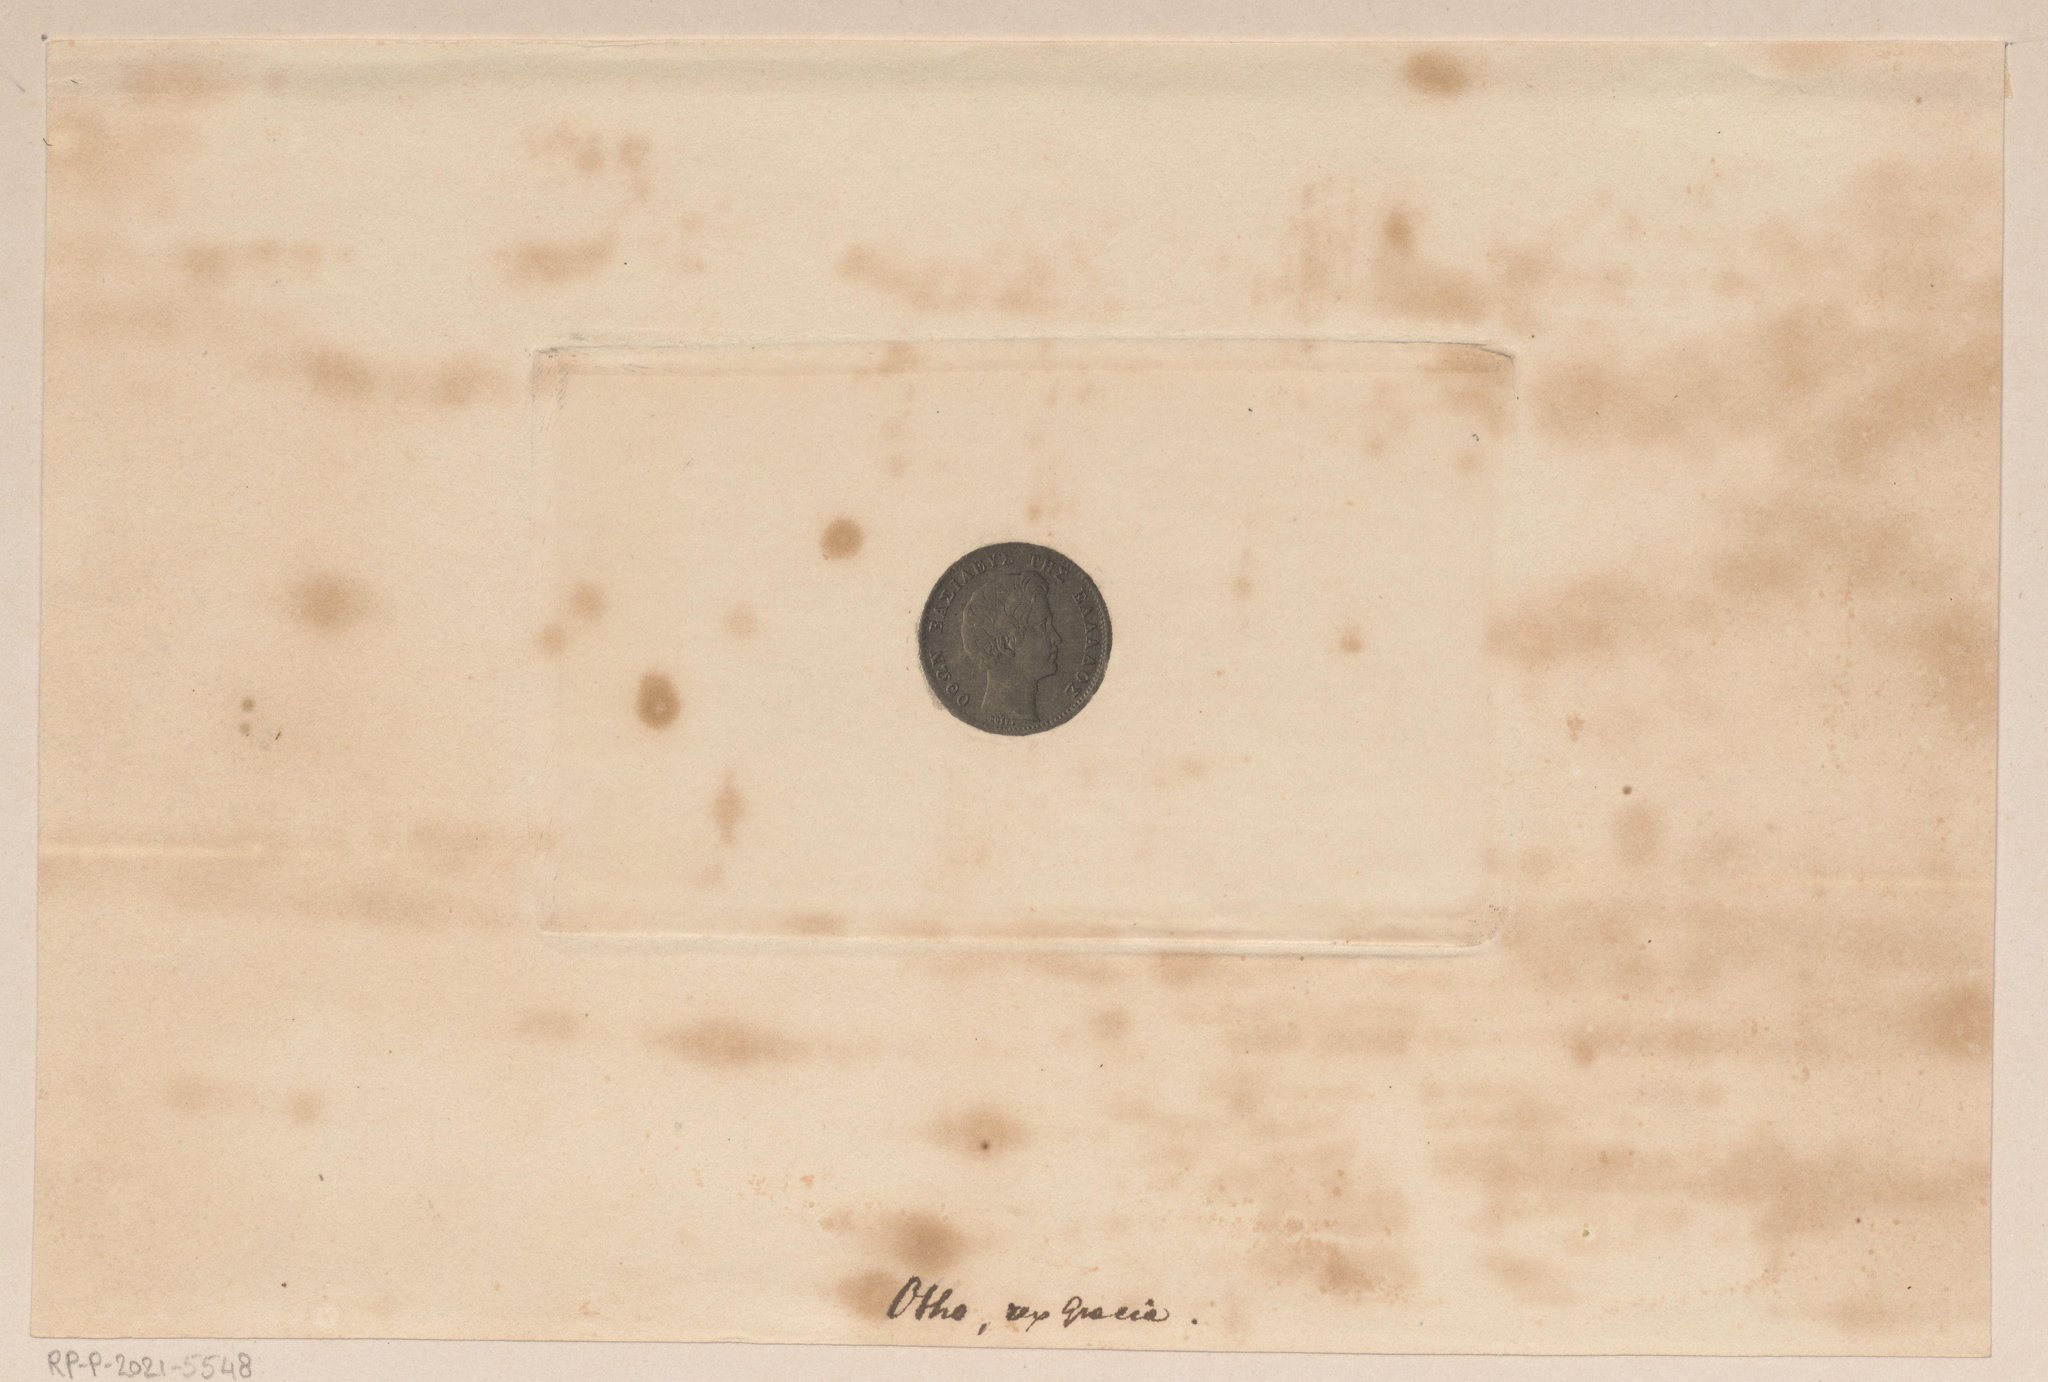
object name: print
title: Munt met het portret van Otto I, koning van Griekenland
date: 1832-1899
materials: paper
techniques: etching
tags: historical persons, king